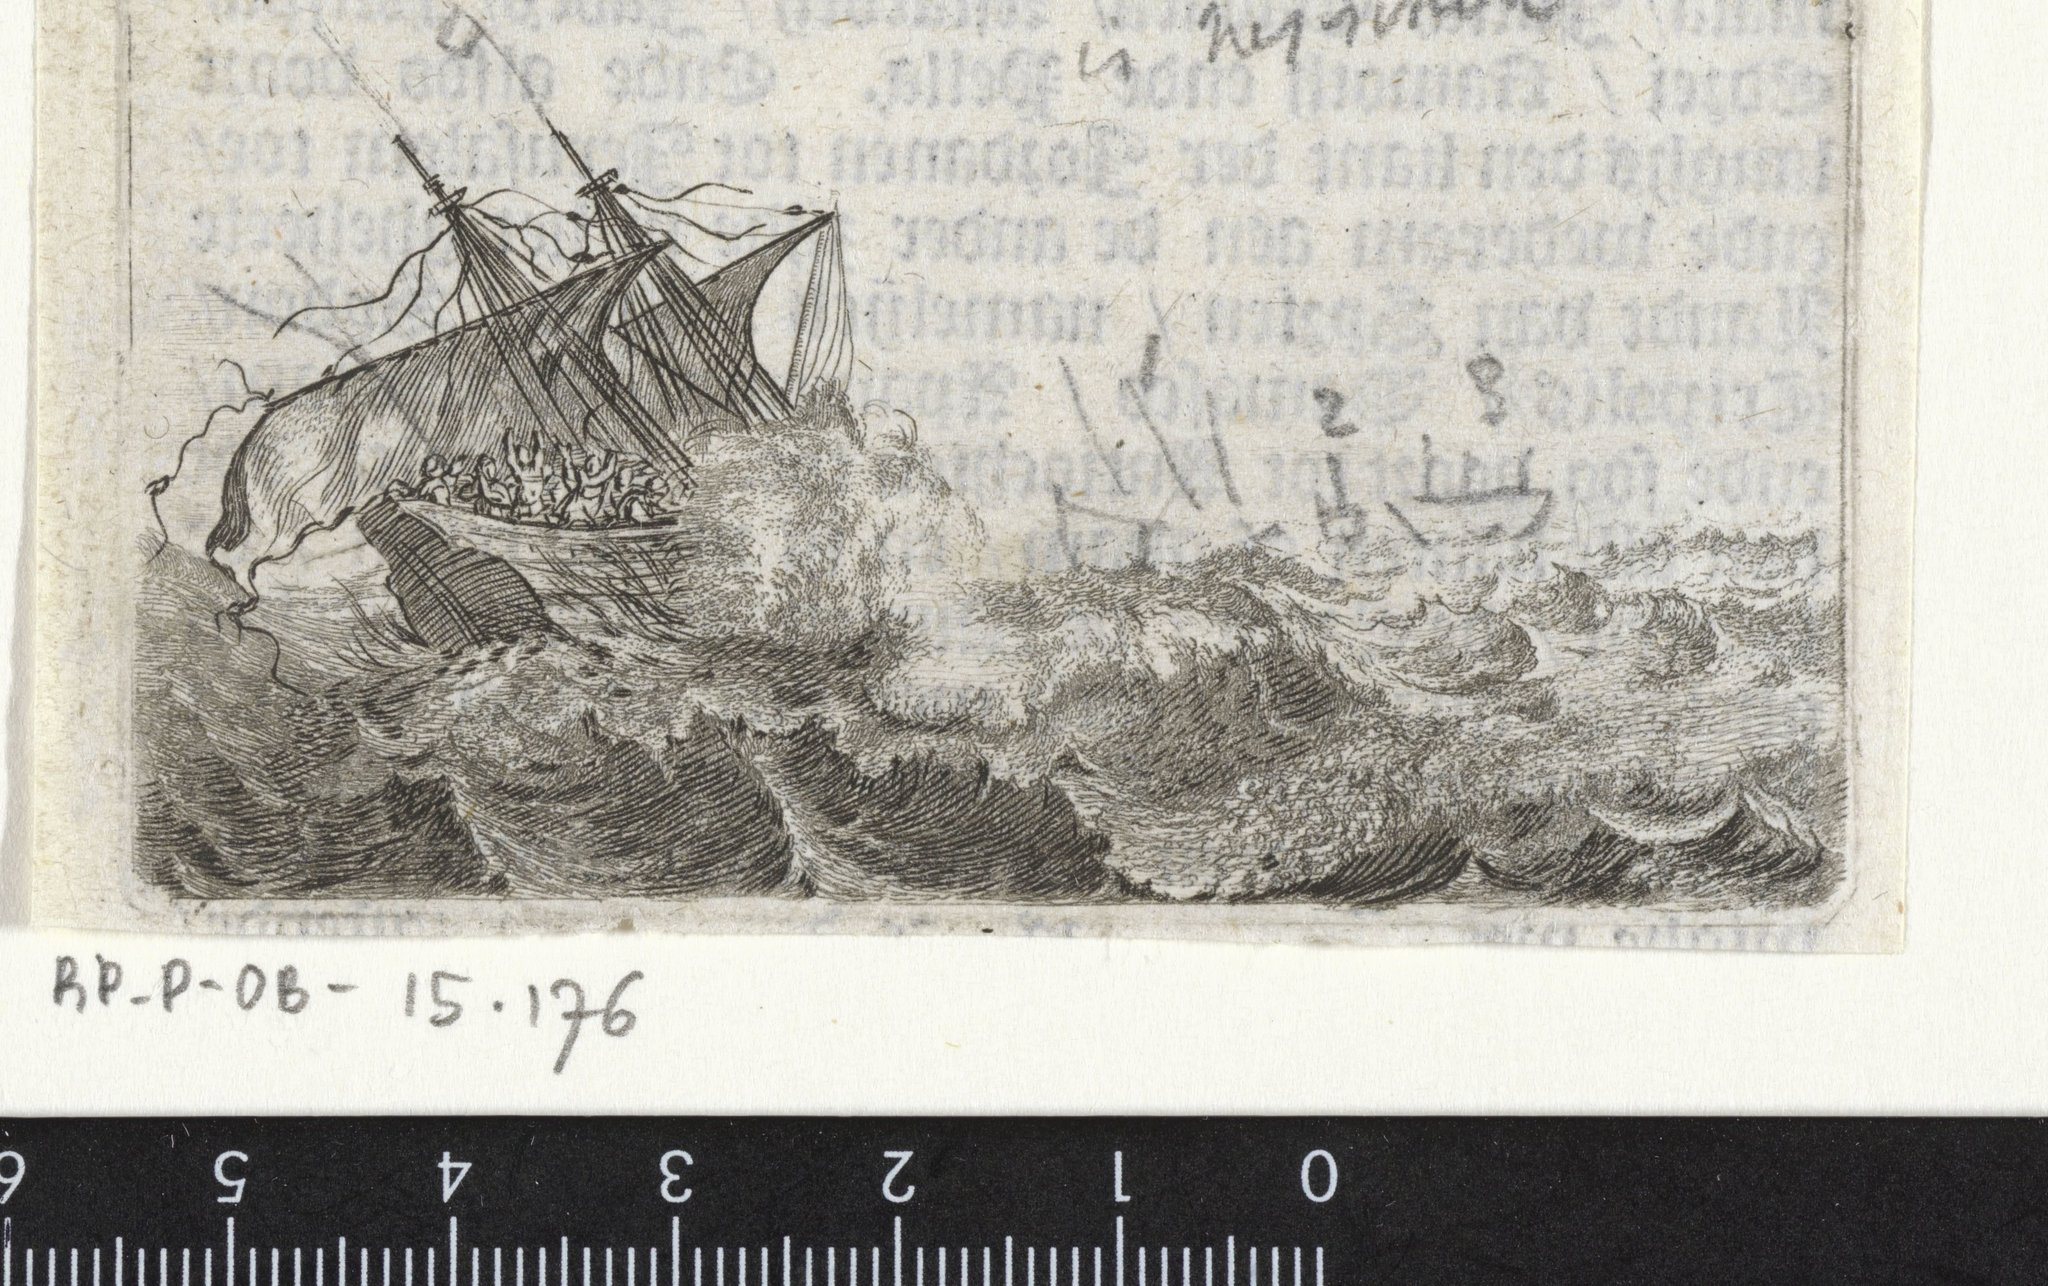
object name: print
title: Zeilsschepen in storm op zee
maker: Anonymous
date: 1605-1703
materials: paper, pencil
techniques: engraving, etching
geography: netherlands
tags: storm